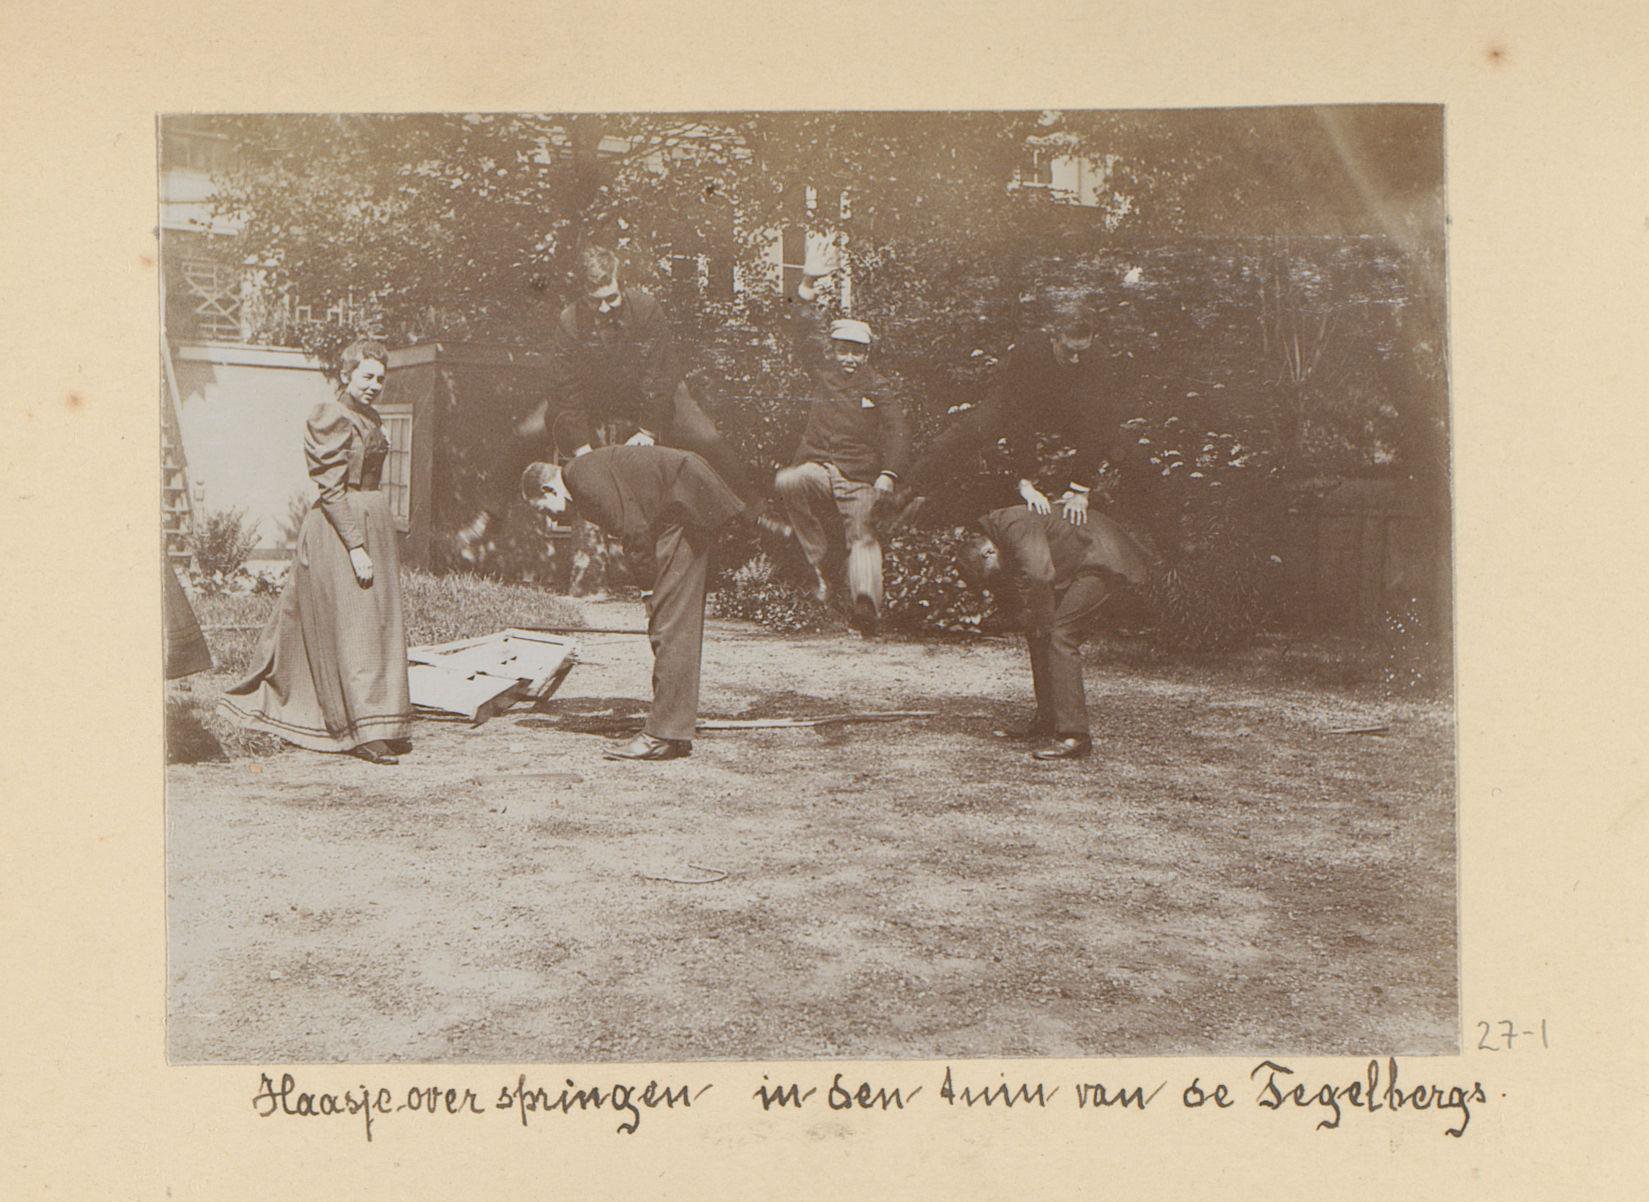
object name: photograph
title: Haasje-over springen in de tuin van de familie Tegelberg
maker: hendrik herman van den berg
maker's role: amateurfotograaf, jurist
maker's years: 1875-1944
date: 1890-1894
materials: paper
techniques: collodion silver print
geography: amsterdam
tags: jumping games, garden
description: Foto 1 op albumblad 27 uit album "Amsterdam 1890-1894".